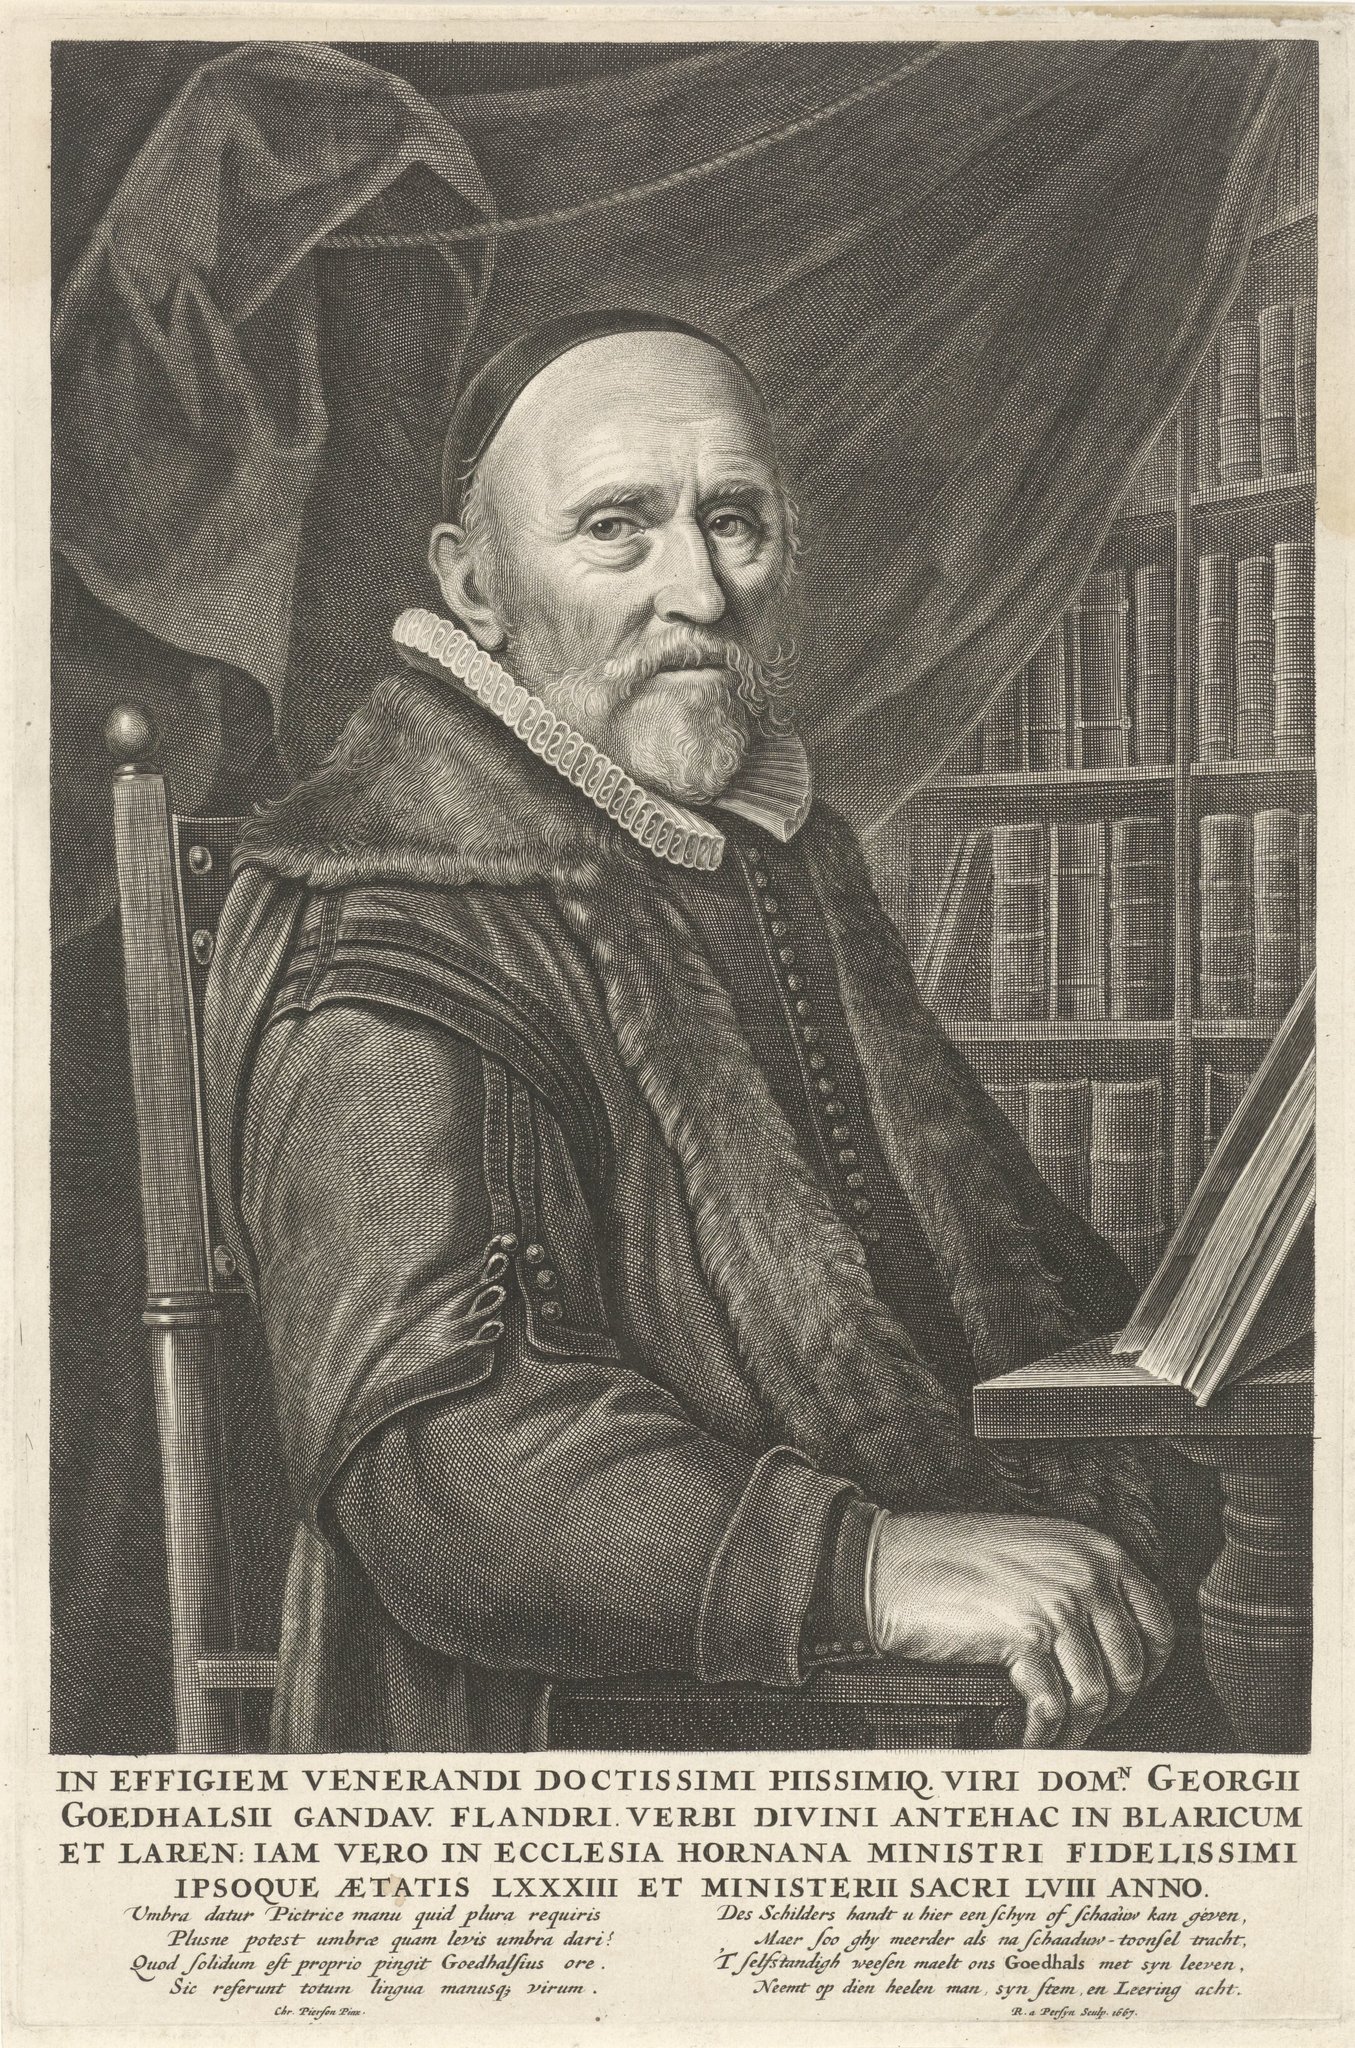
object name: print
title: Portret van George Goethals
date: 1667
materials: paper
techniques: engraving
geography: gouda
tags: study; 'studiolo'; library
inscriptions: collector's mark: Lugt 2228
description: Portret van George Goethals, op 83-jarige leeftijd, predikant te Blaricum en Laren. In de marge een vierregelig onderschrift met de naam en functie van de geportretteerde in het Latijn. Daaronder een vierregelig lofdicht in het Latijn en in het Nederlands.